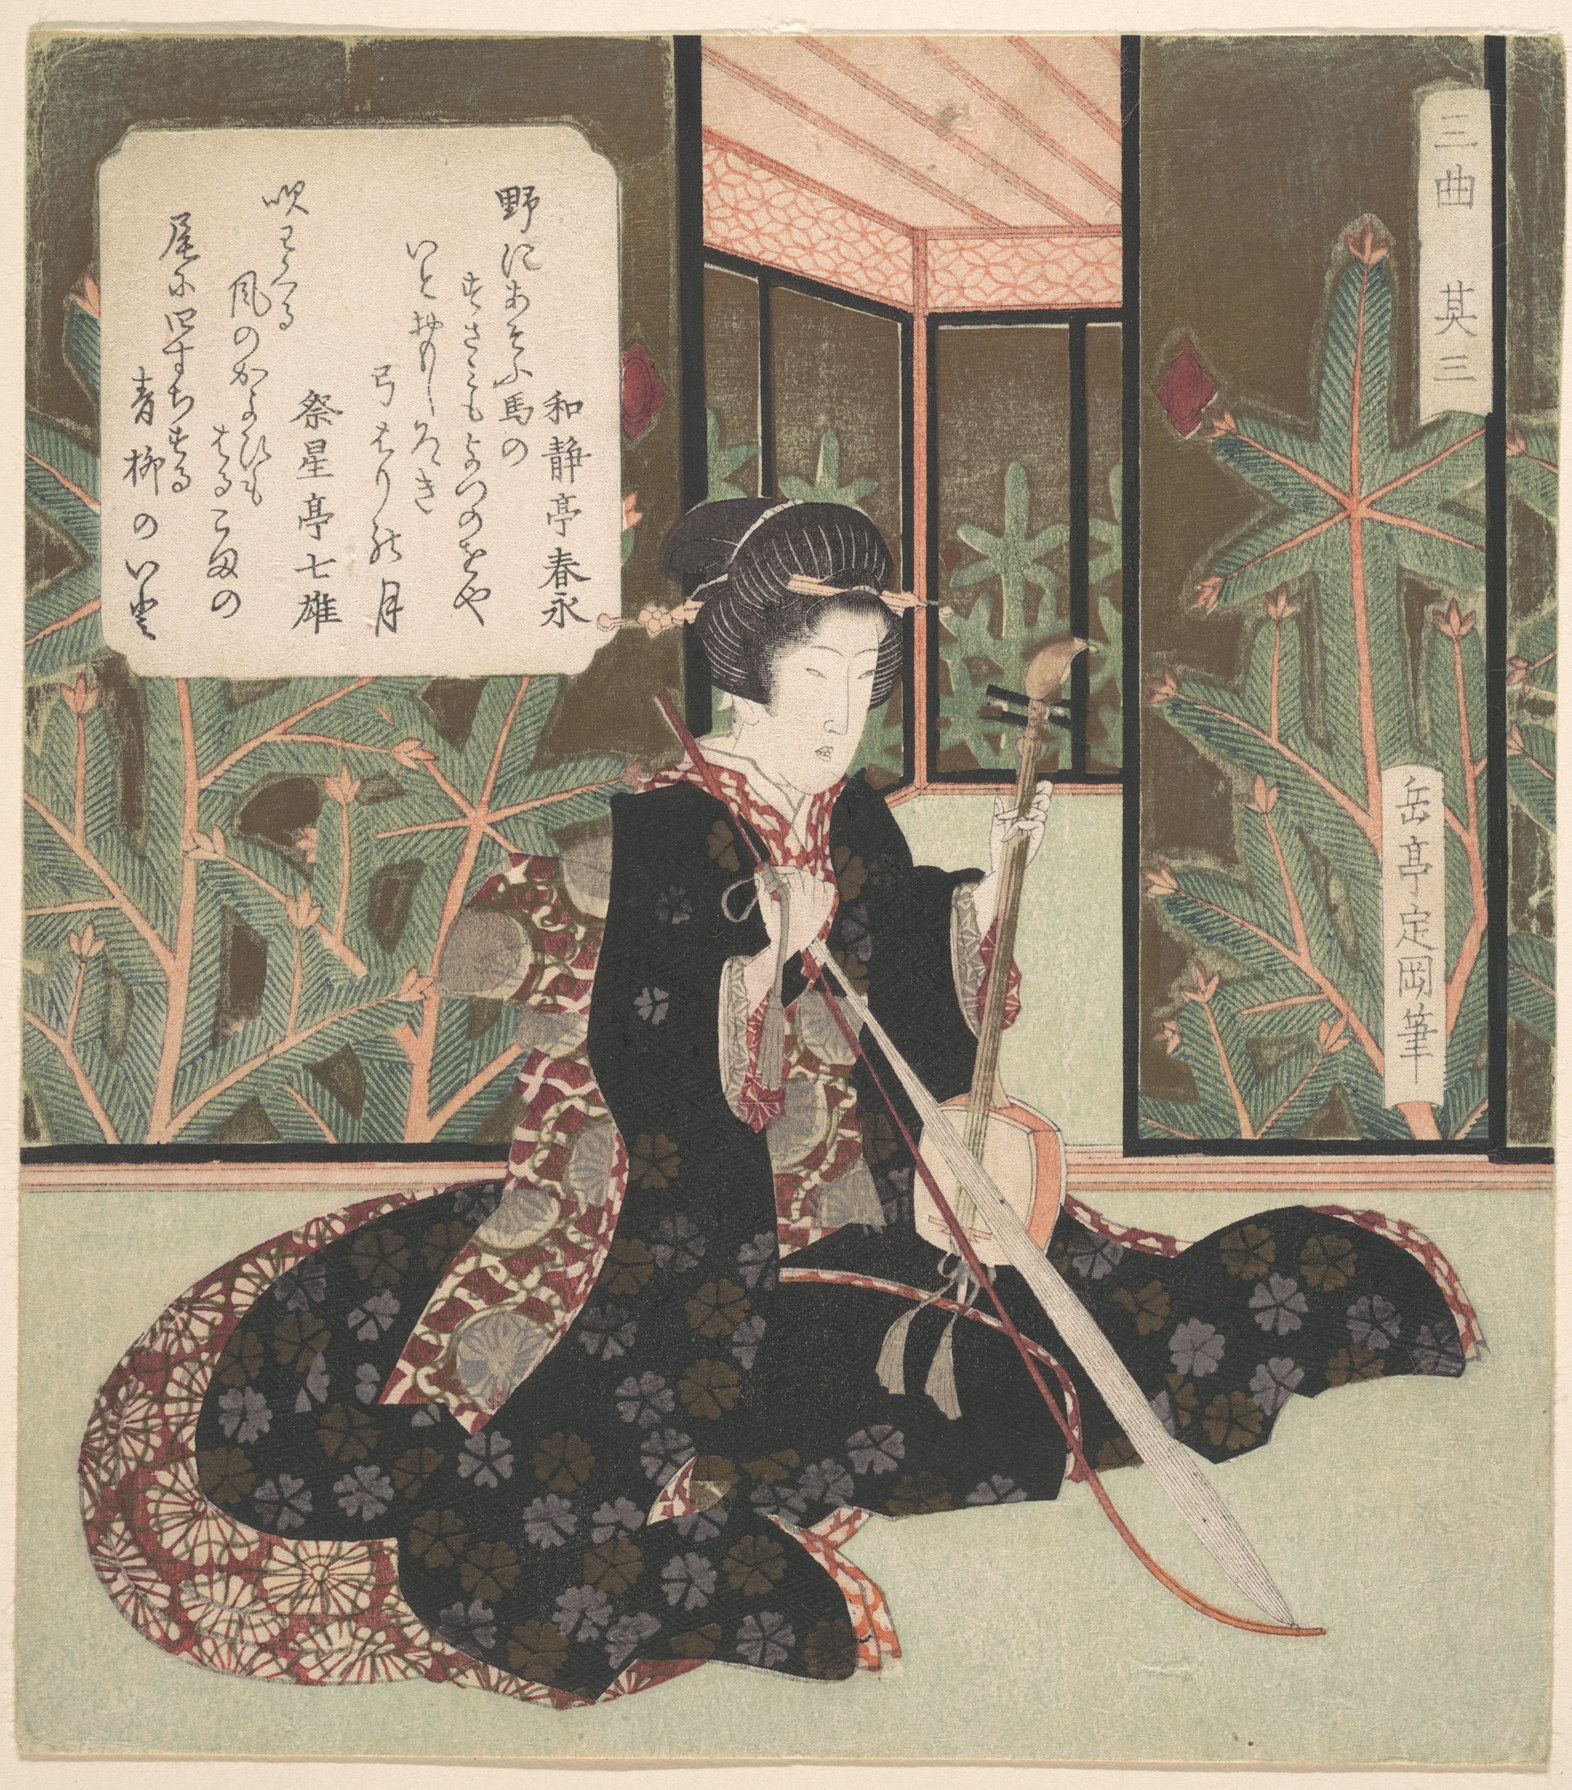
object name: print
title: Trio, Part Three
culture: japanese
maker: yashima gakutei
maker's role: artist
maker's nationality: japanese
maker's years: 1786-1868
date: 1786-1868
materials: ink, paper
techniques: surimono, woodblock print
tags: musical instruments,women,music